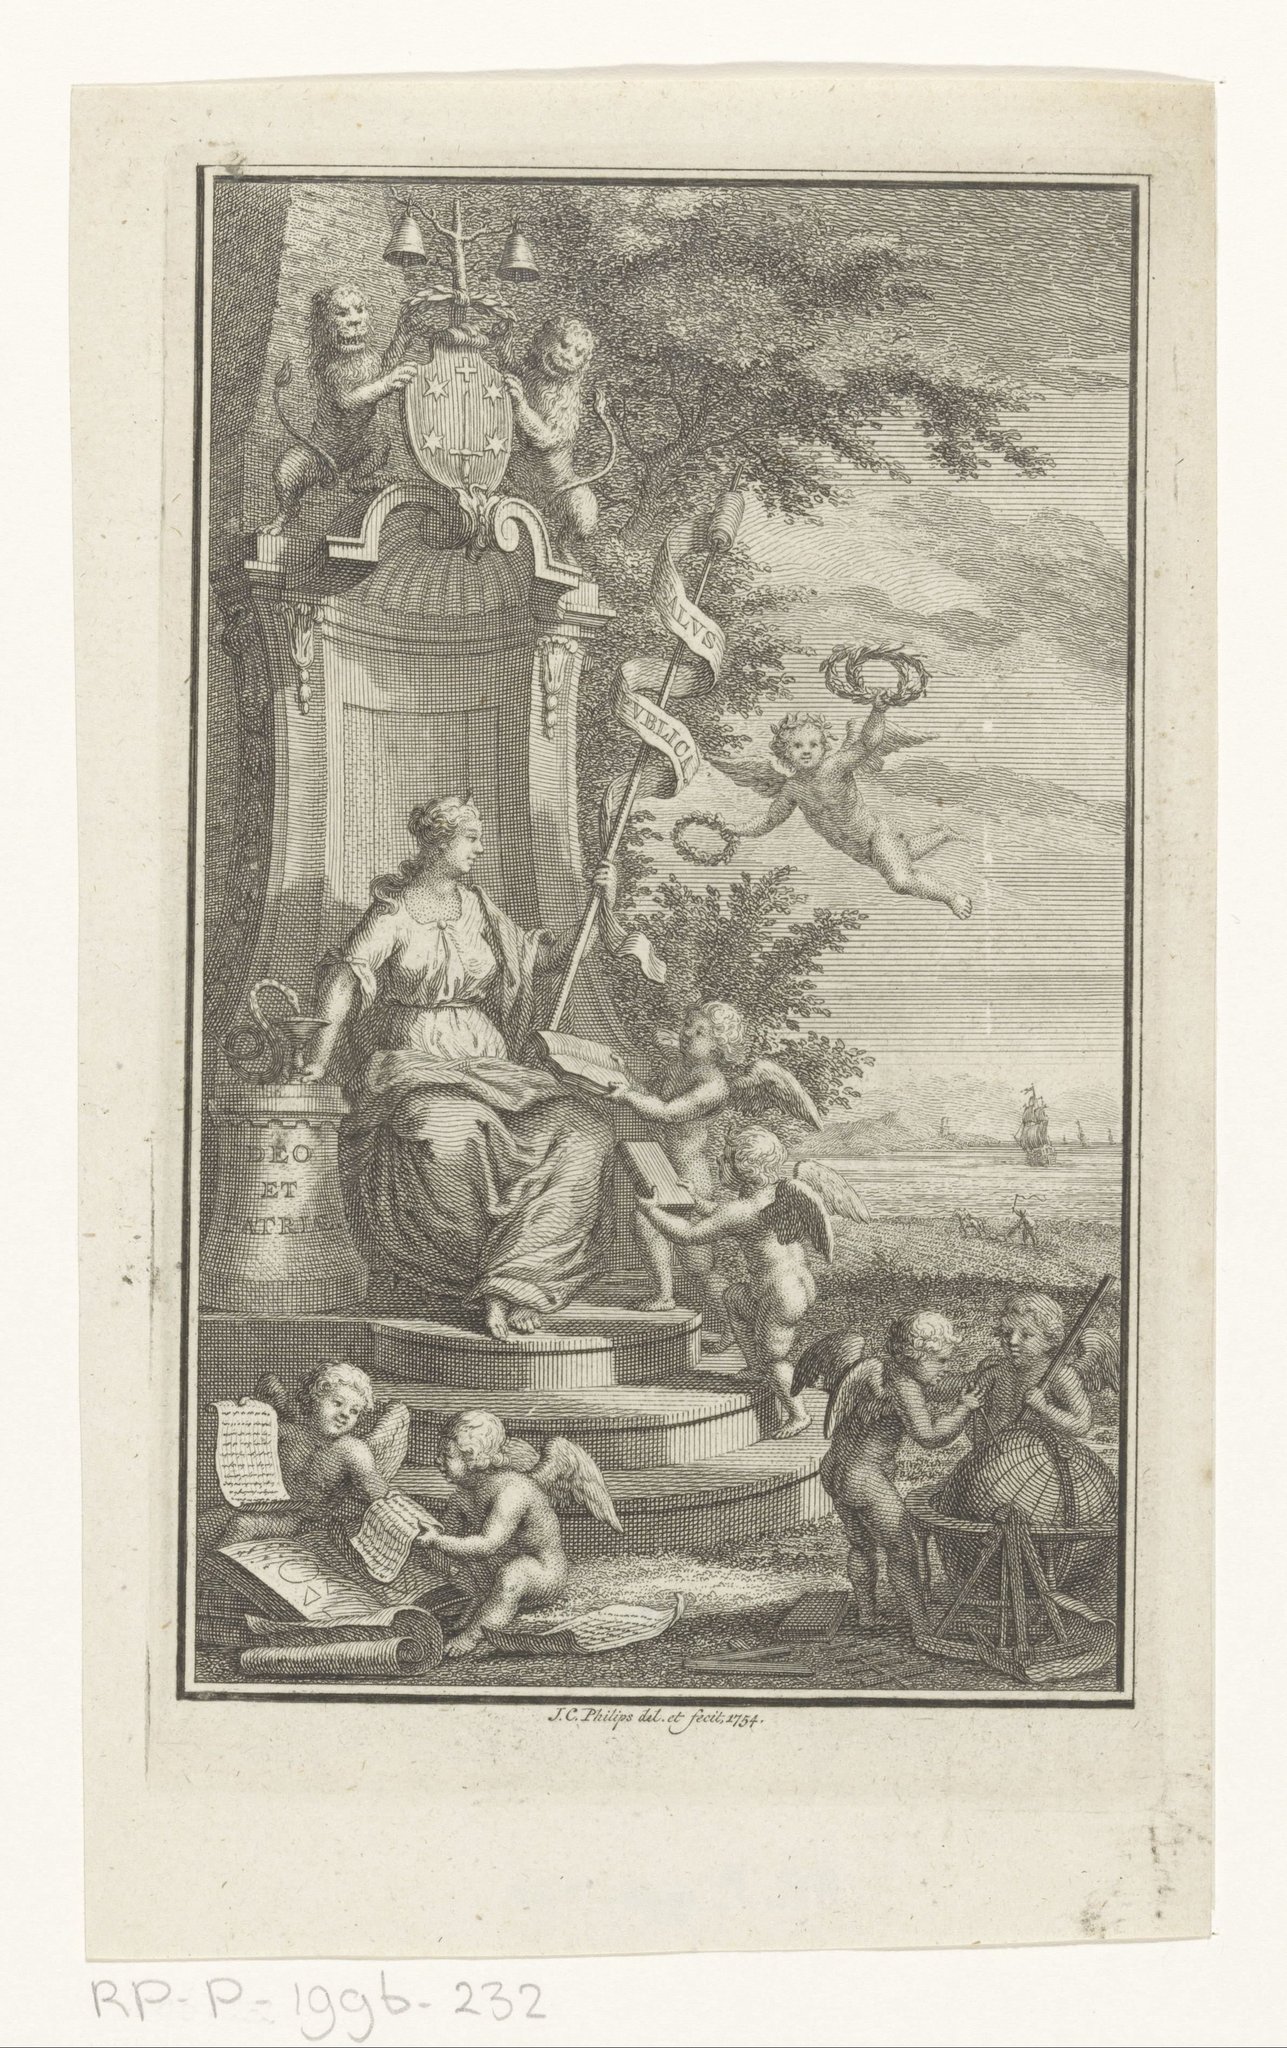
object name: print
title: Deo et patriae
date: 1754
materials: paper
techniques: engraving, etching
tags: sailing-ship, sailing-boat, symbolic representations, allegories and emblems ~ science, 'scientia'; 'scienza', 'studio' (ripa), personification of a city, town-patron(ess), cupids: 'amores', 'amoretti', 'putti', haarlem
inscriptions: collector's mark: Lugt 2760, collector's mark: Lugt 2228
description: De stedenmaagd van Haarlem zit onder het wapen van Haarlem met een staf met banderol in haar handen. Op de banderol staat: Salus Publica, algemeen welzijn. Zij laat haar hand rusten op een voetstuk met de woorden: Deo et Patriae. Voor de troon putti met papieren en boeken, passer en meetlat en een globe. Allegorische voorstelling waarin de stad Haarlem als bevorderaar van de wetenschap en de kunsten wordt voorgesteld.